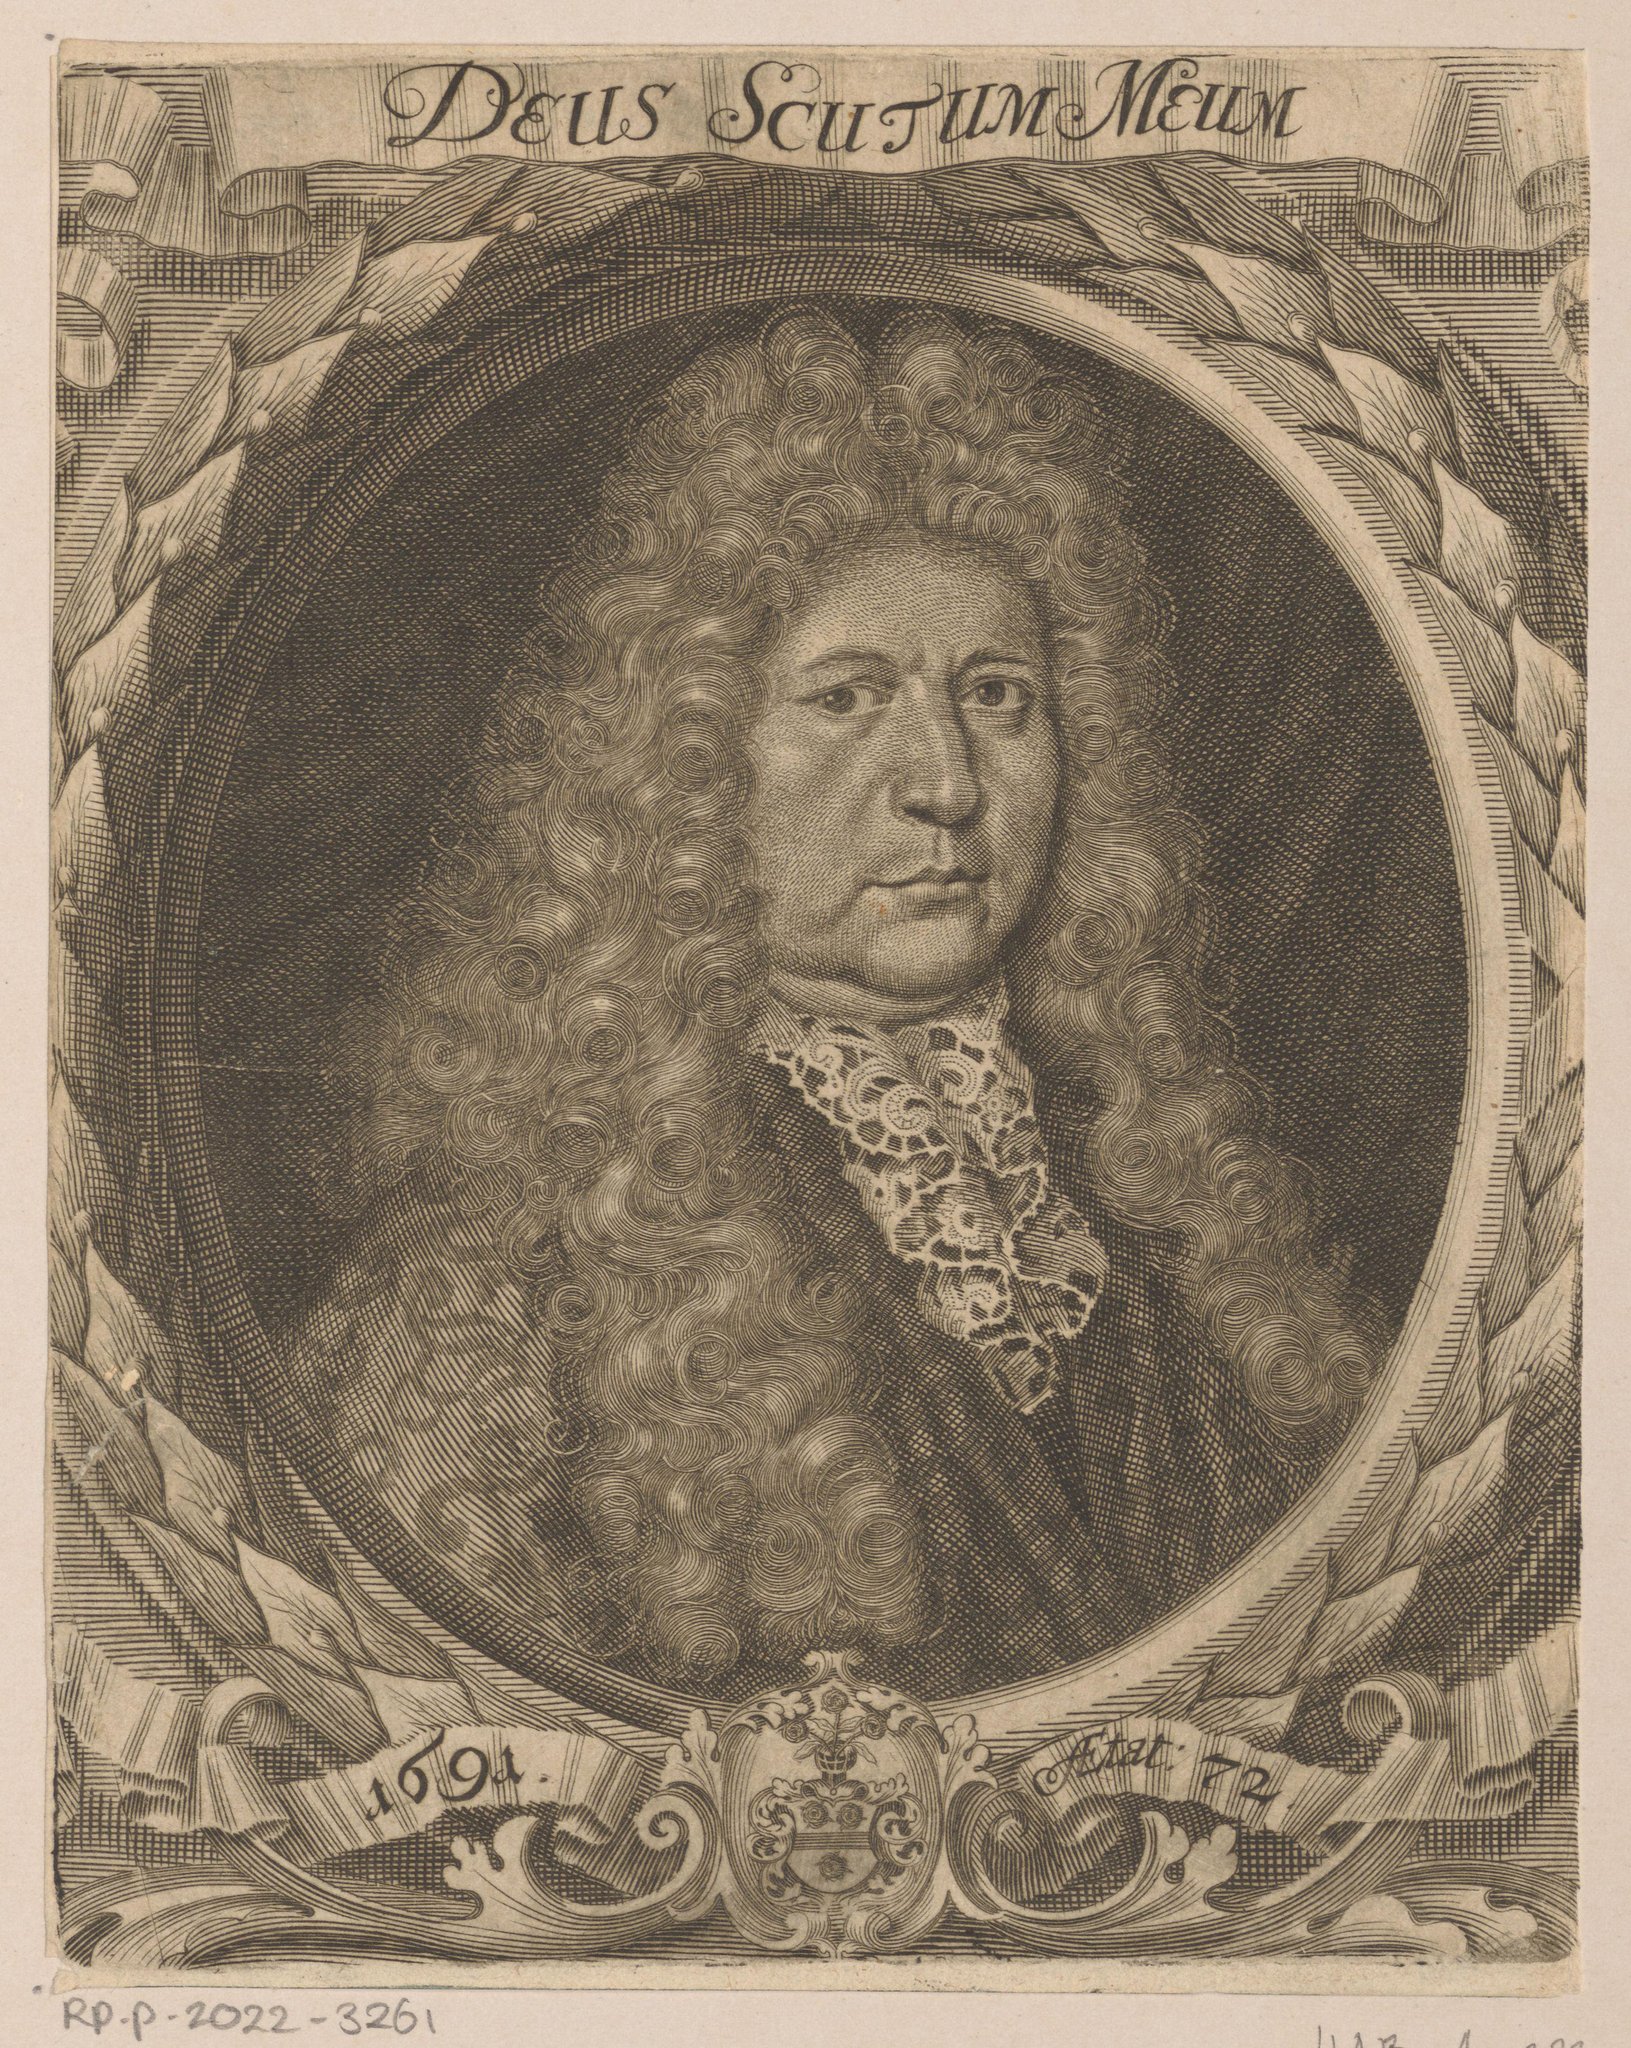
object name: print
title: Portret van Georg Adam Struve op 72-jarige leeftijd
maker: Anonymous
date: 1691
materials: paper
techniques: engraving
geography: germany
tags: historical persons, armorial bearing, heraldry